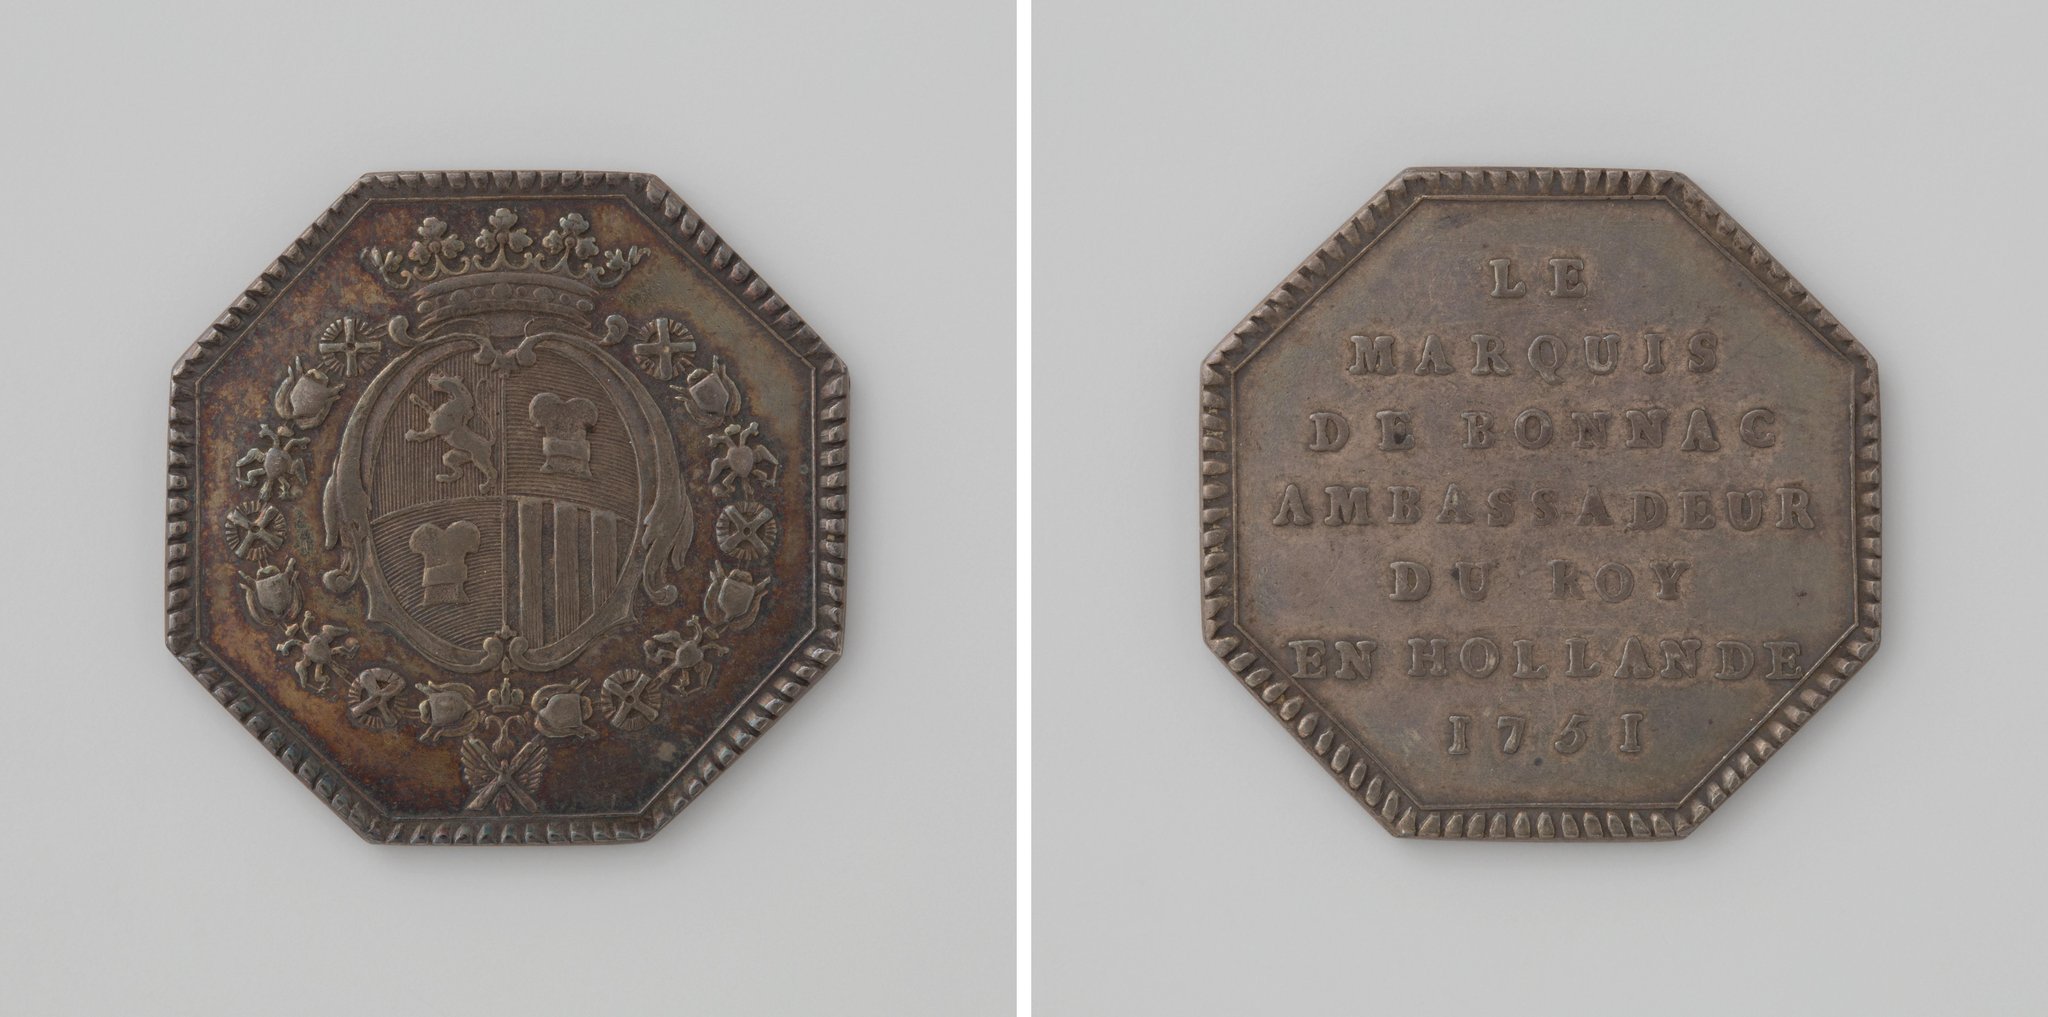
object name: history medal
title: Francois-Armand d'Usson, markies de Bonnac, Frans afgezant in de Nederlanden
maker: Anonymous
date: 1751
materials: silver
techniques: striking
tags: france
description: Zilveren achthoekige penning. Voorzijde: gekroond wapenschild omhangen met de orde van St. Andries. Keerzijde: opschrift.